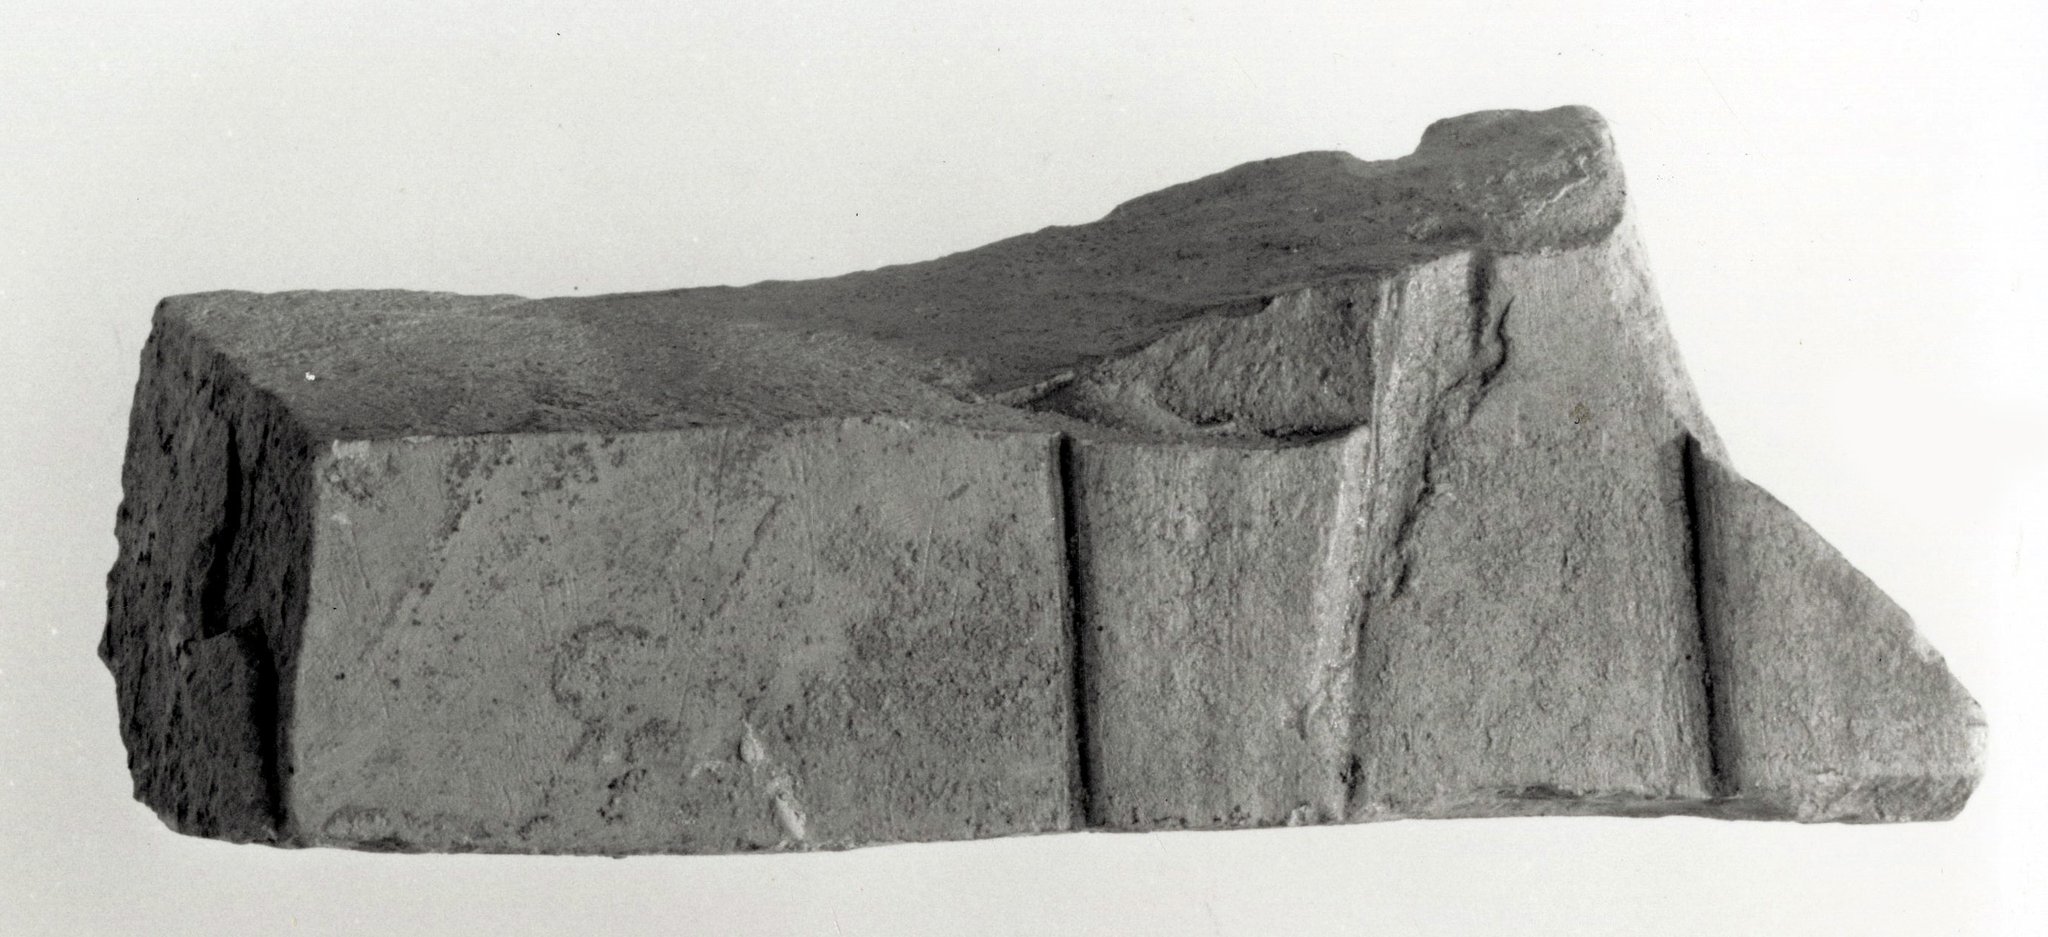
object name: relief, tomb of nespekashuty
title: Raised relief fragment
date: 664-610 BCE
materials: limestone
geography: egypt